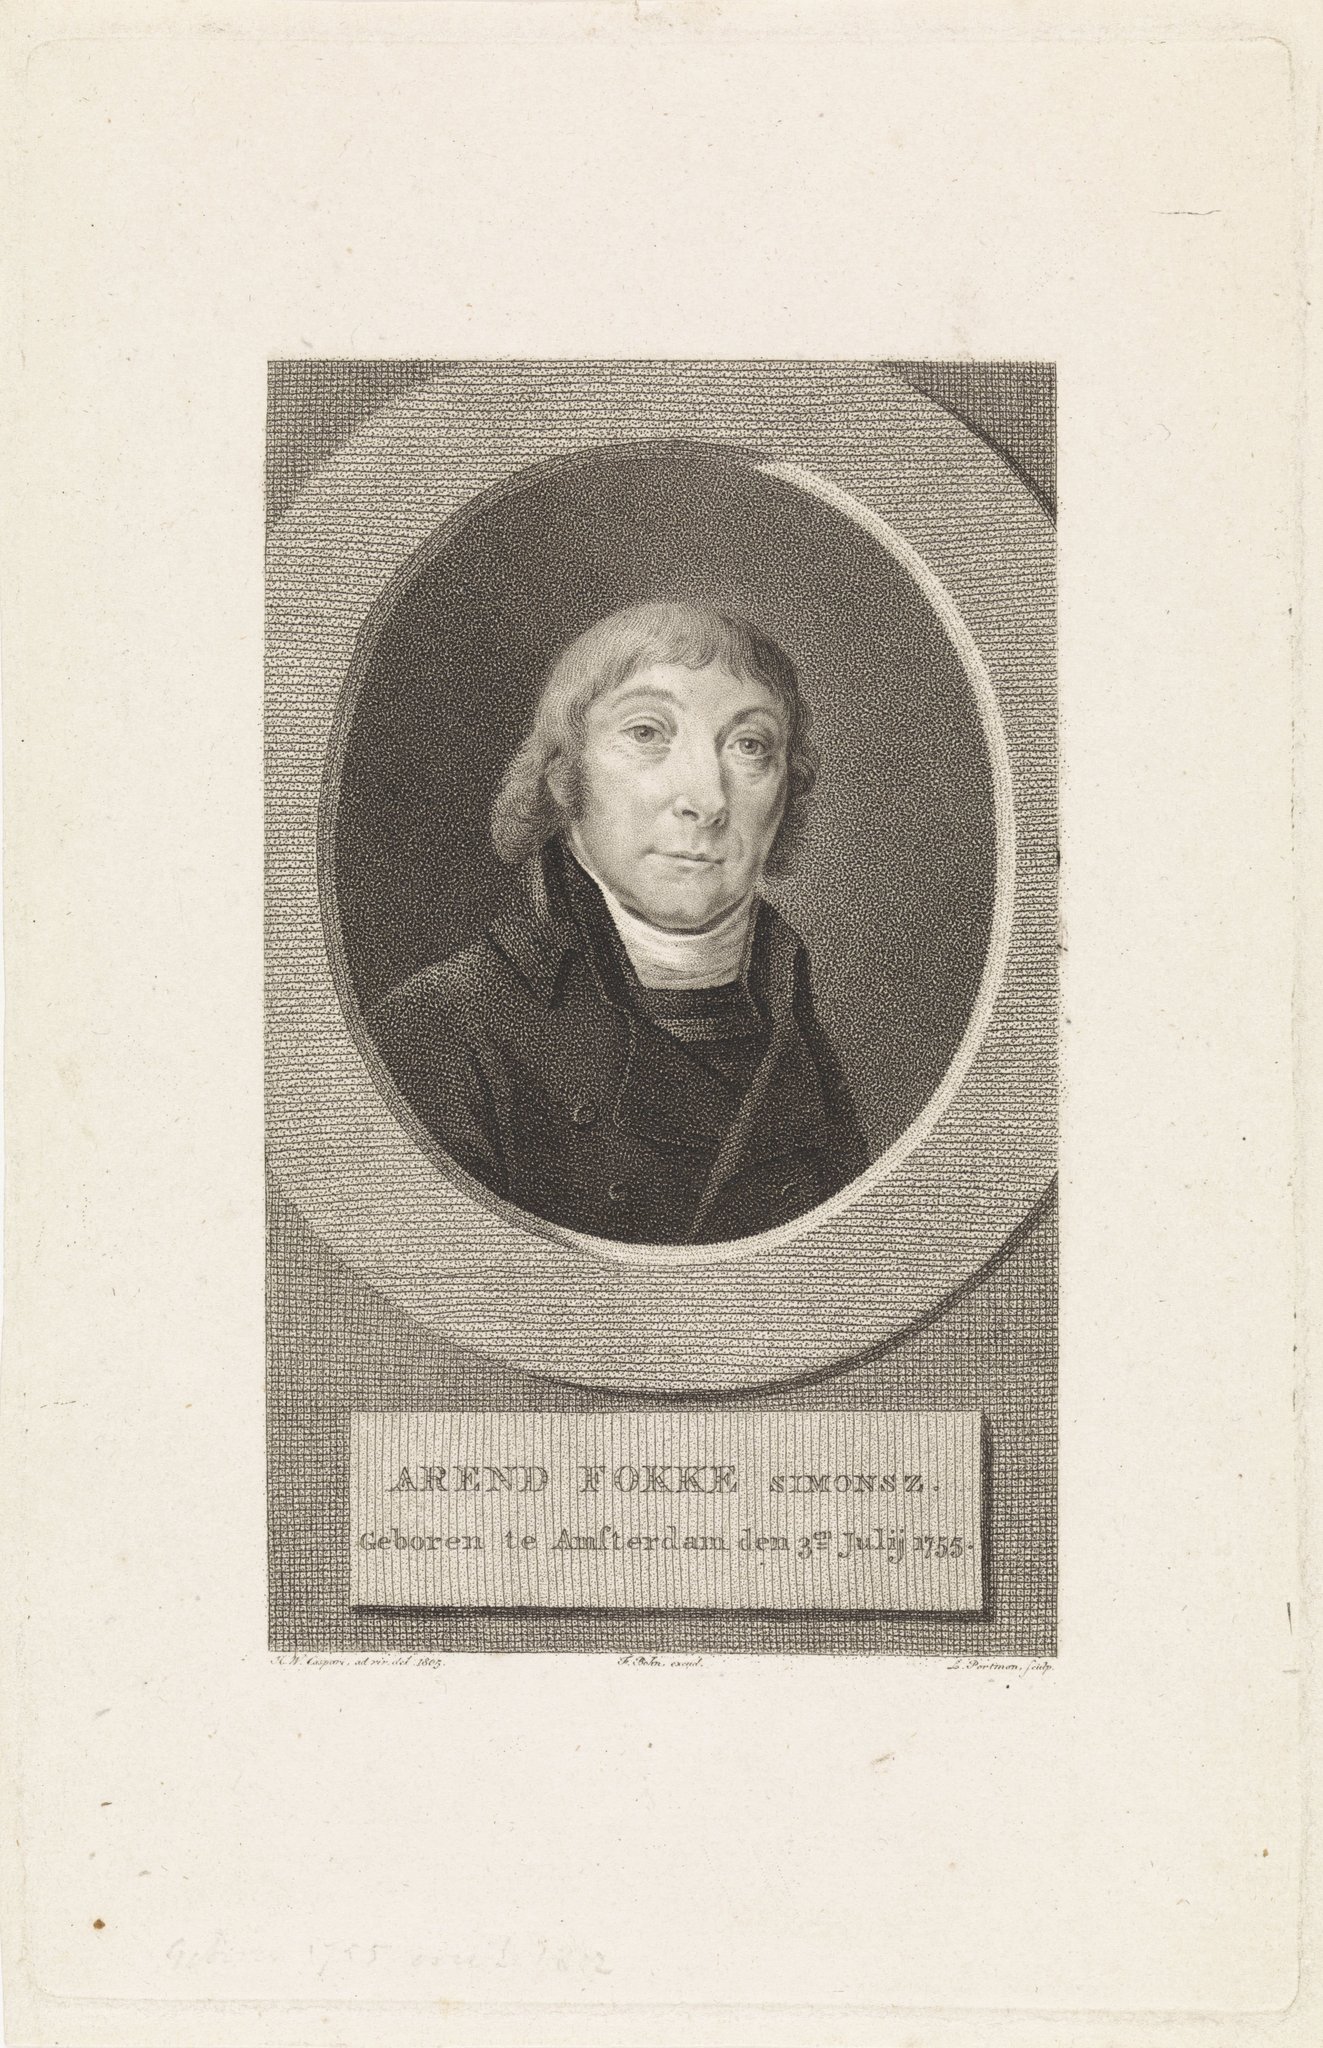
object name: print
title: Portret van de dichter Arend Fokke Simonsz.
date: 1805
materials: paper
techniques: stippled etching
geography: haarlem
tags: amsterdam, arend fokke simonsz., portrait of a writer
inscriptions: collector's mark: Lugt 2228